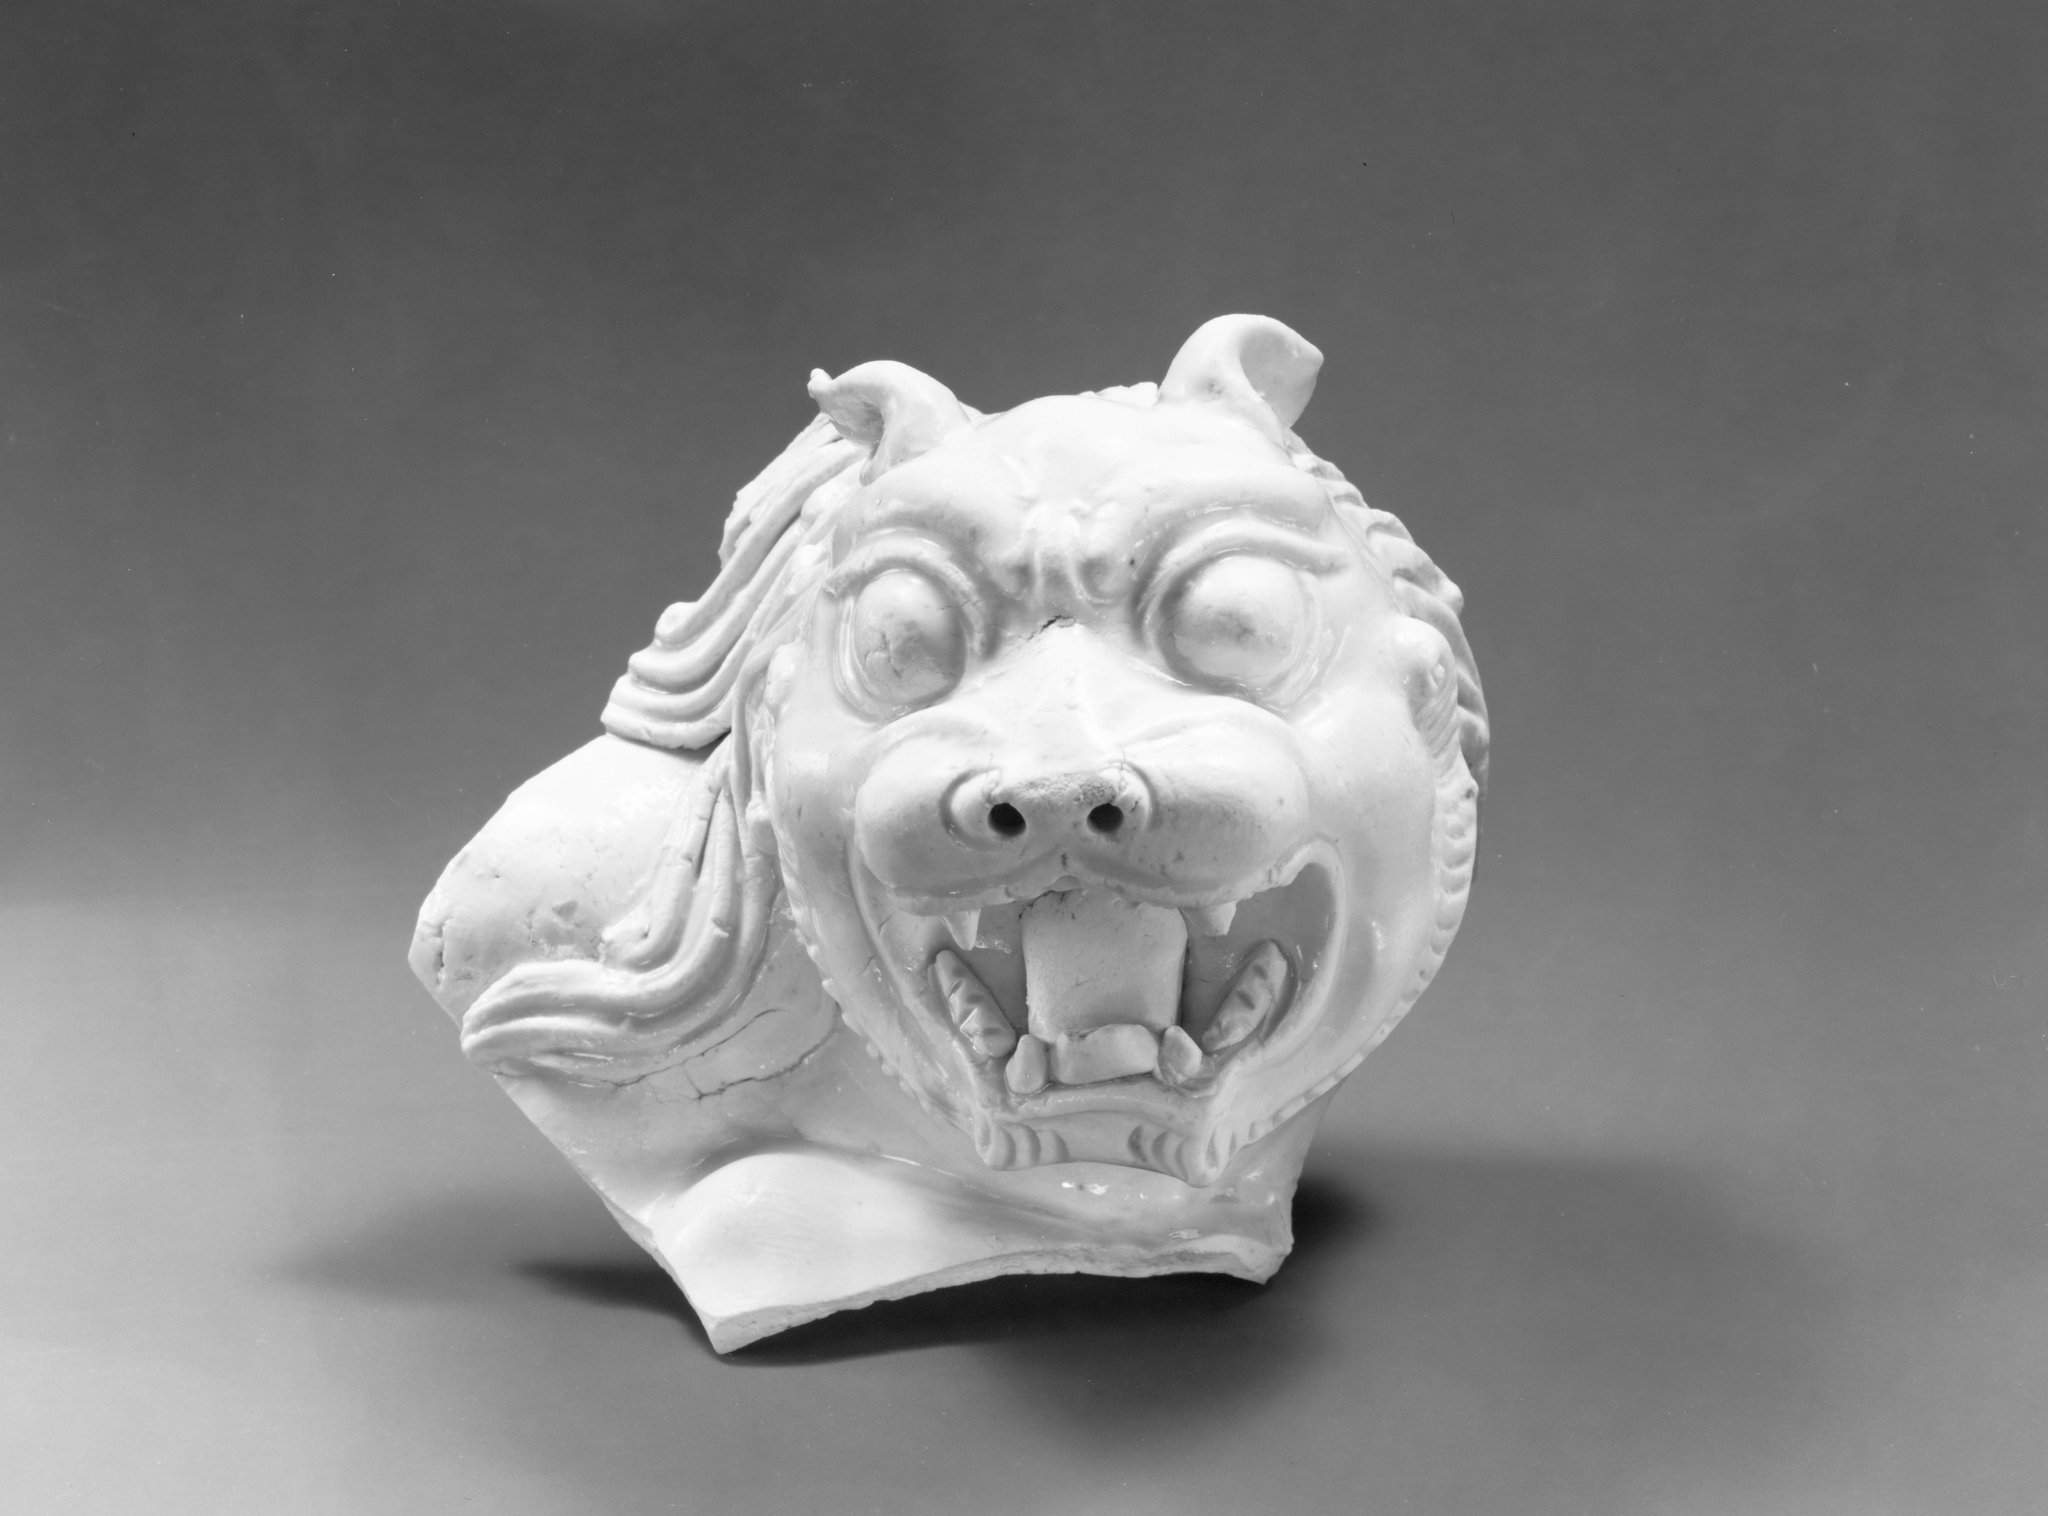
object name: head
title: Head of a Lion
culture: chinese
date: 1001-1200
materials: glaze, ivory, porcelain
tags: lions